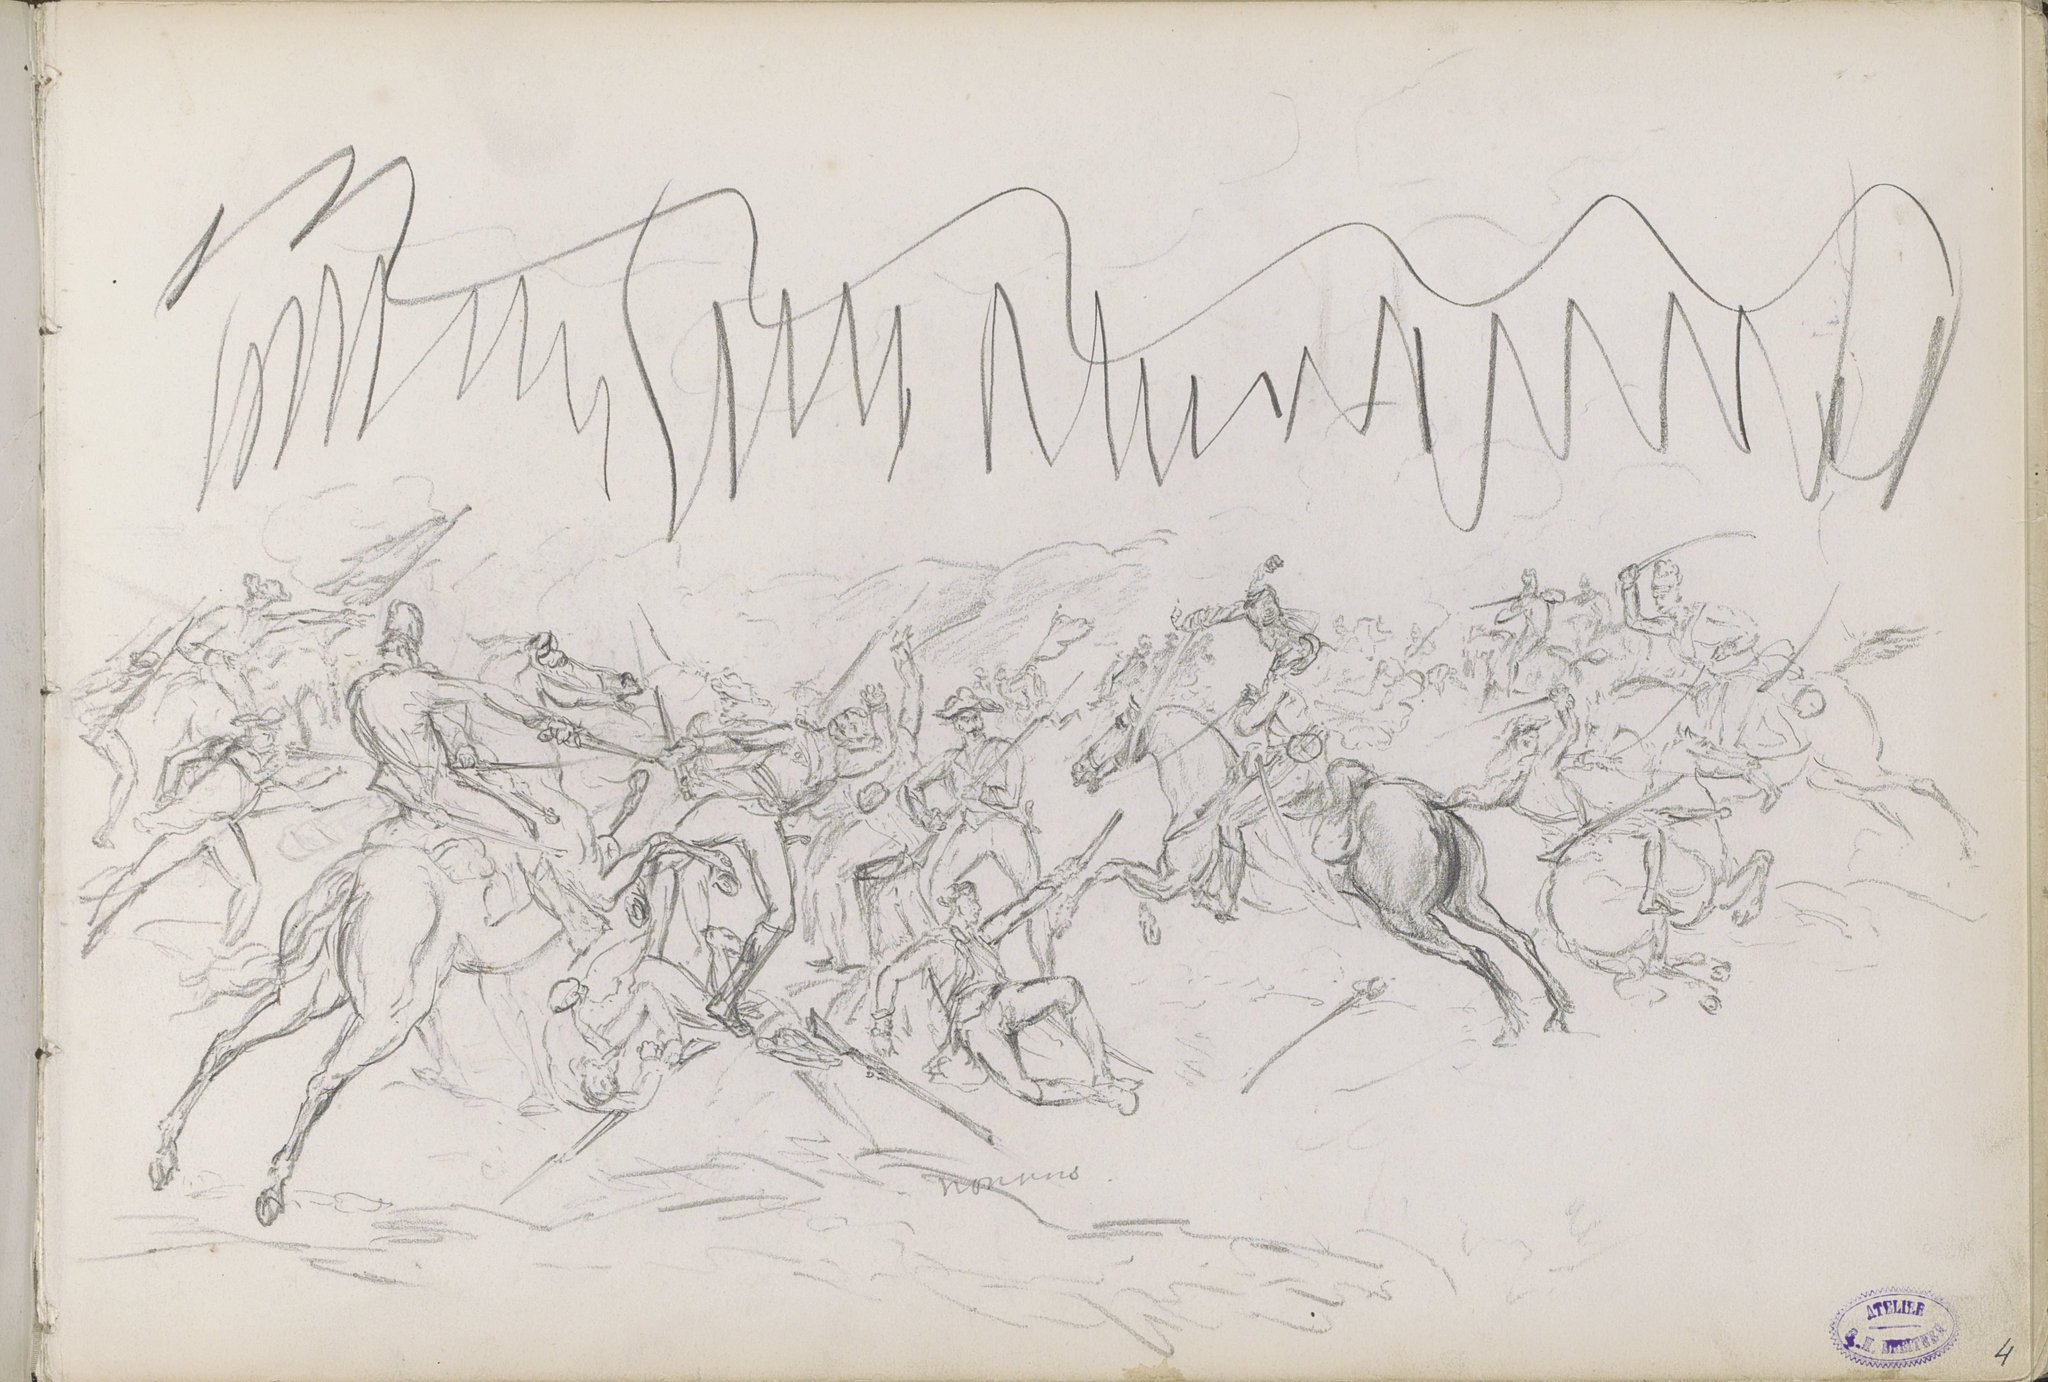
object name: sketchbook leaf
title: Strijdende soldaten te paard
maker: george hendrik breitner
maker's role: draughtsman, painter, print maker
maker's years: 1857-1923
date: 1873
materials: paper, pencil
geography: rotterdam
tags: division of armed forces (+ during the battle), division of armed forces (+ cavalry, horsemen)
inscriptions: workshop stamp: Lugt 291d, annotation: ‘Nonners[?]’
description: Blad 4 recto uit een schetsboek met 25 bladen.